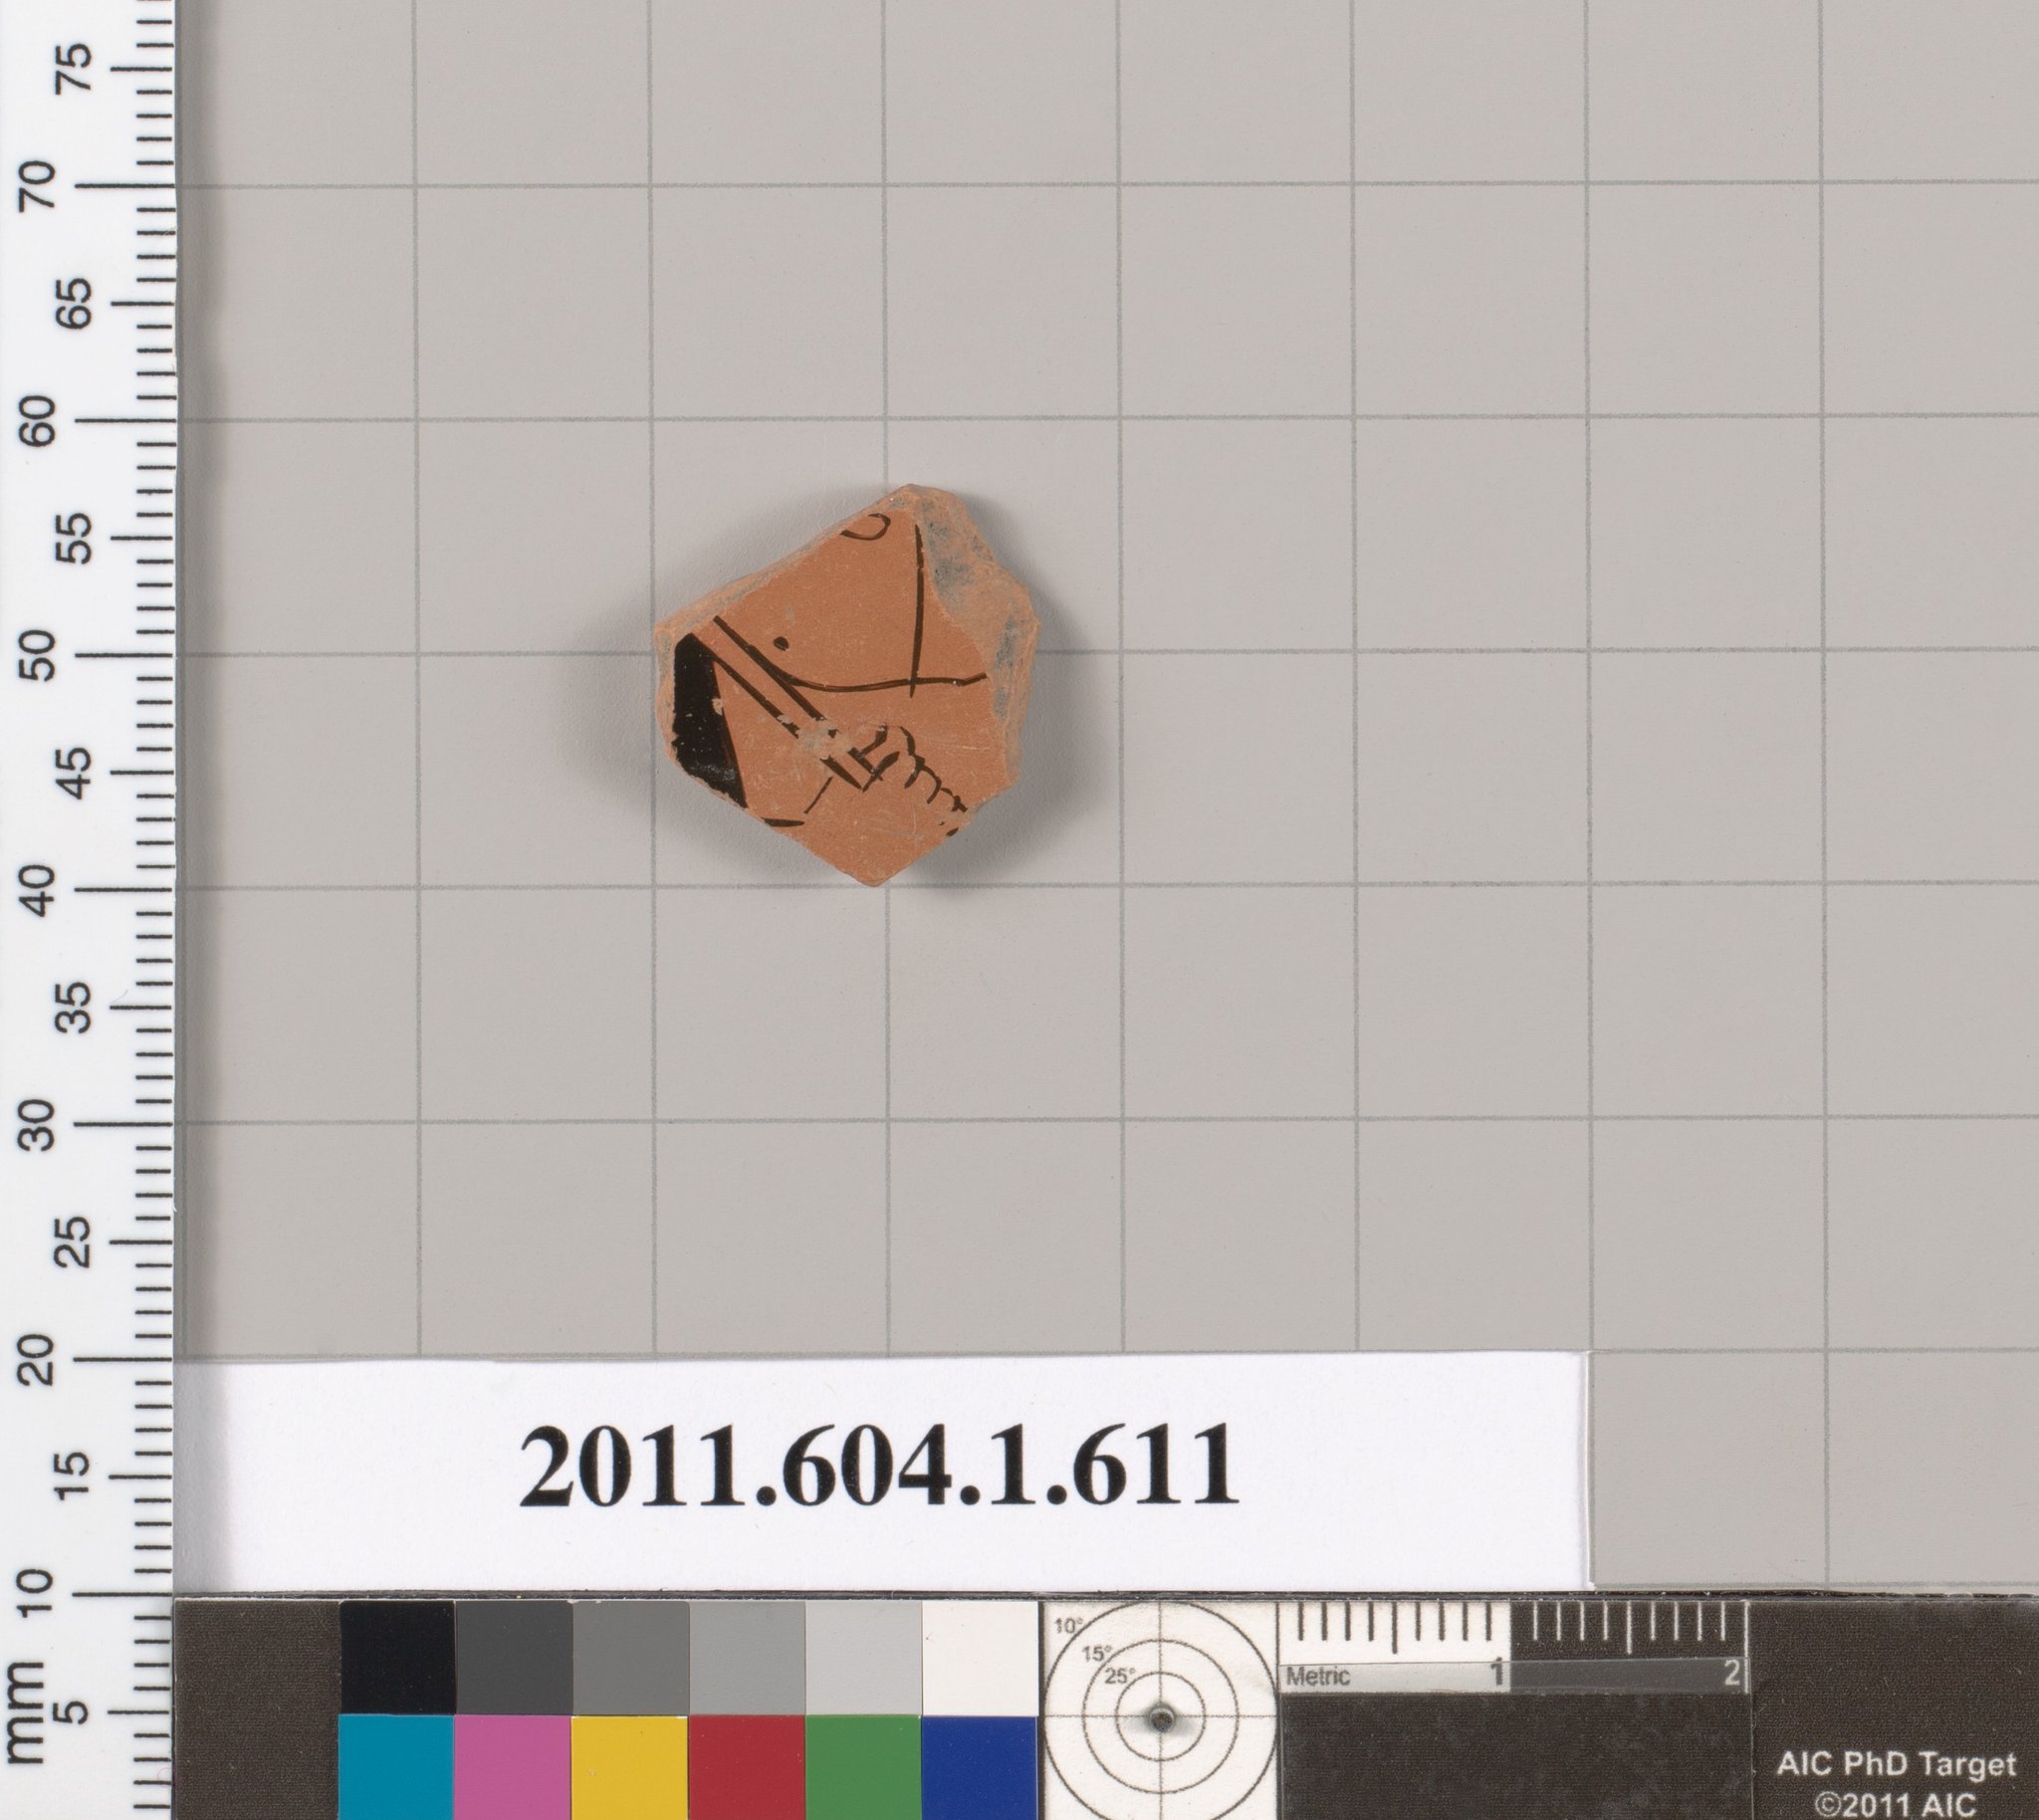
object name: kylix fragment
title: Terracotta fragment of a kylix (drinking cup)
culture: greek, attic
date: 475-451 BCE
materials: terracotta